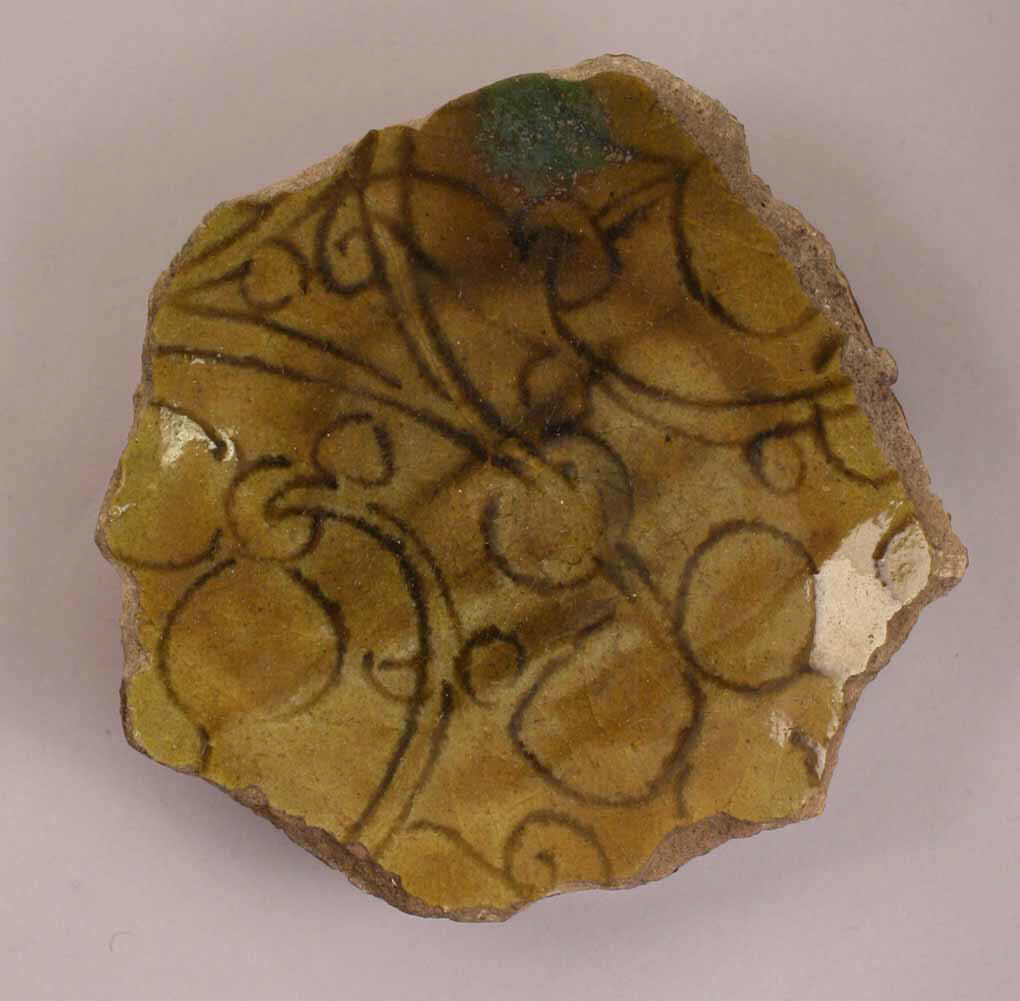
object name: ceramic fragment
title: Fragment of a Bowl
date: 1201-1400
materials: earthenware, glaze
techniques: incising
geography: egypt